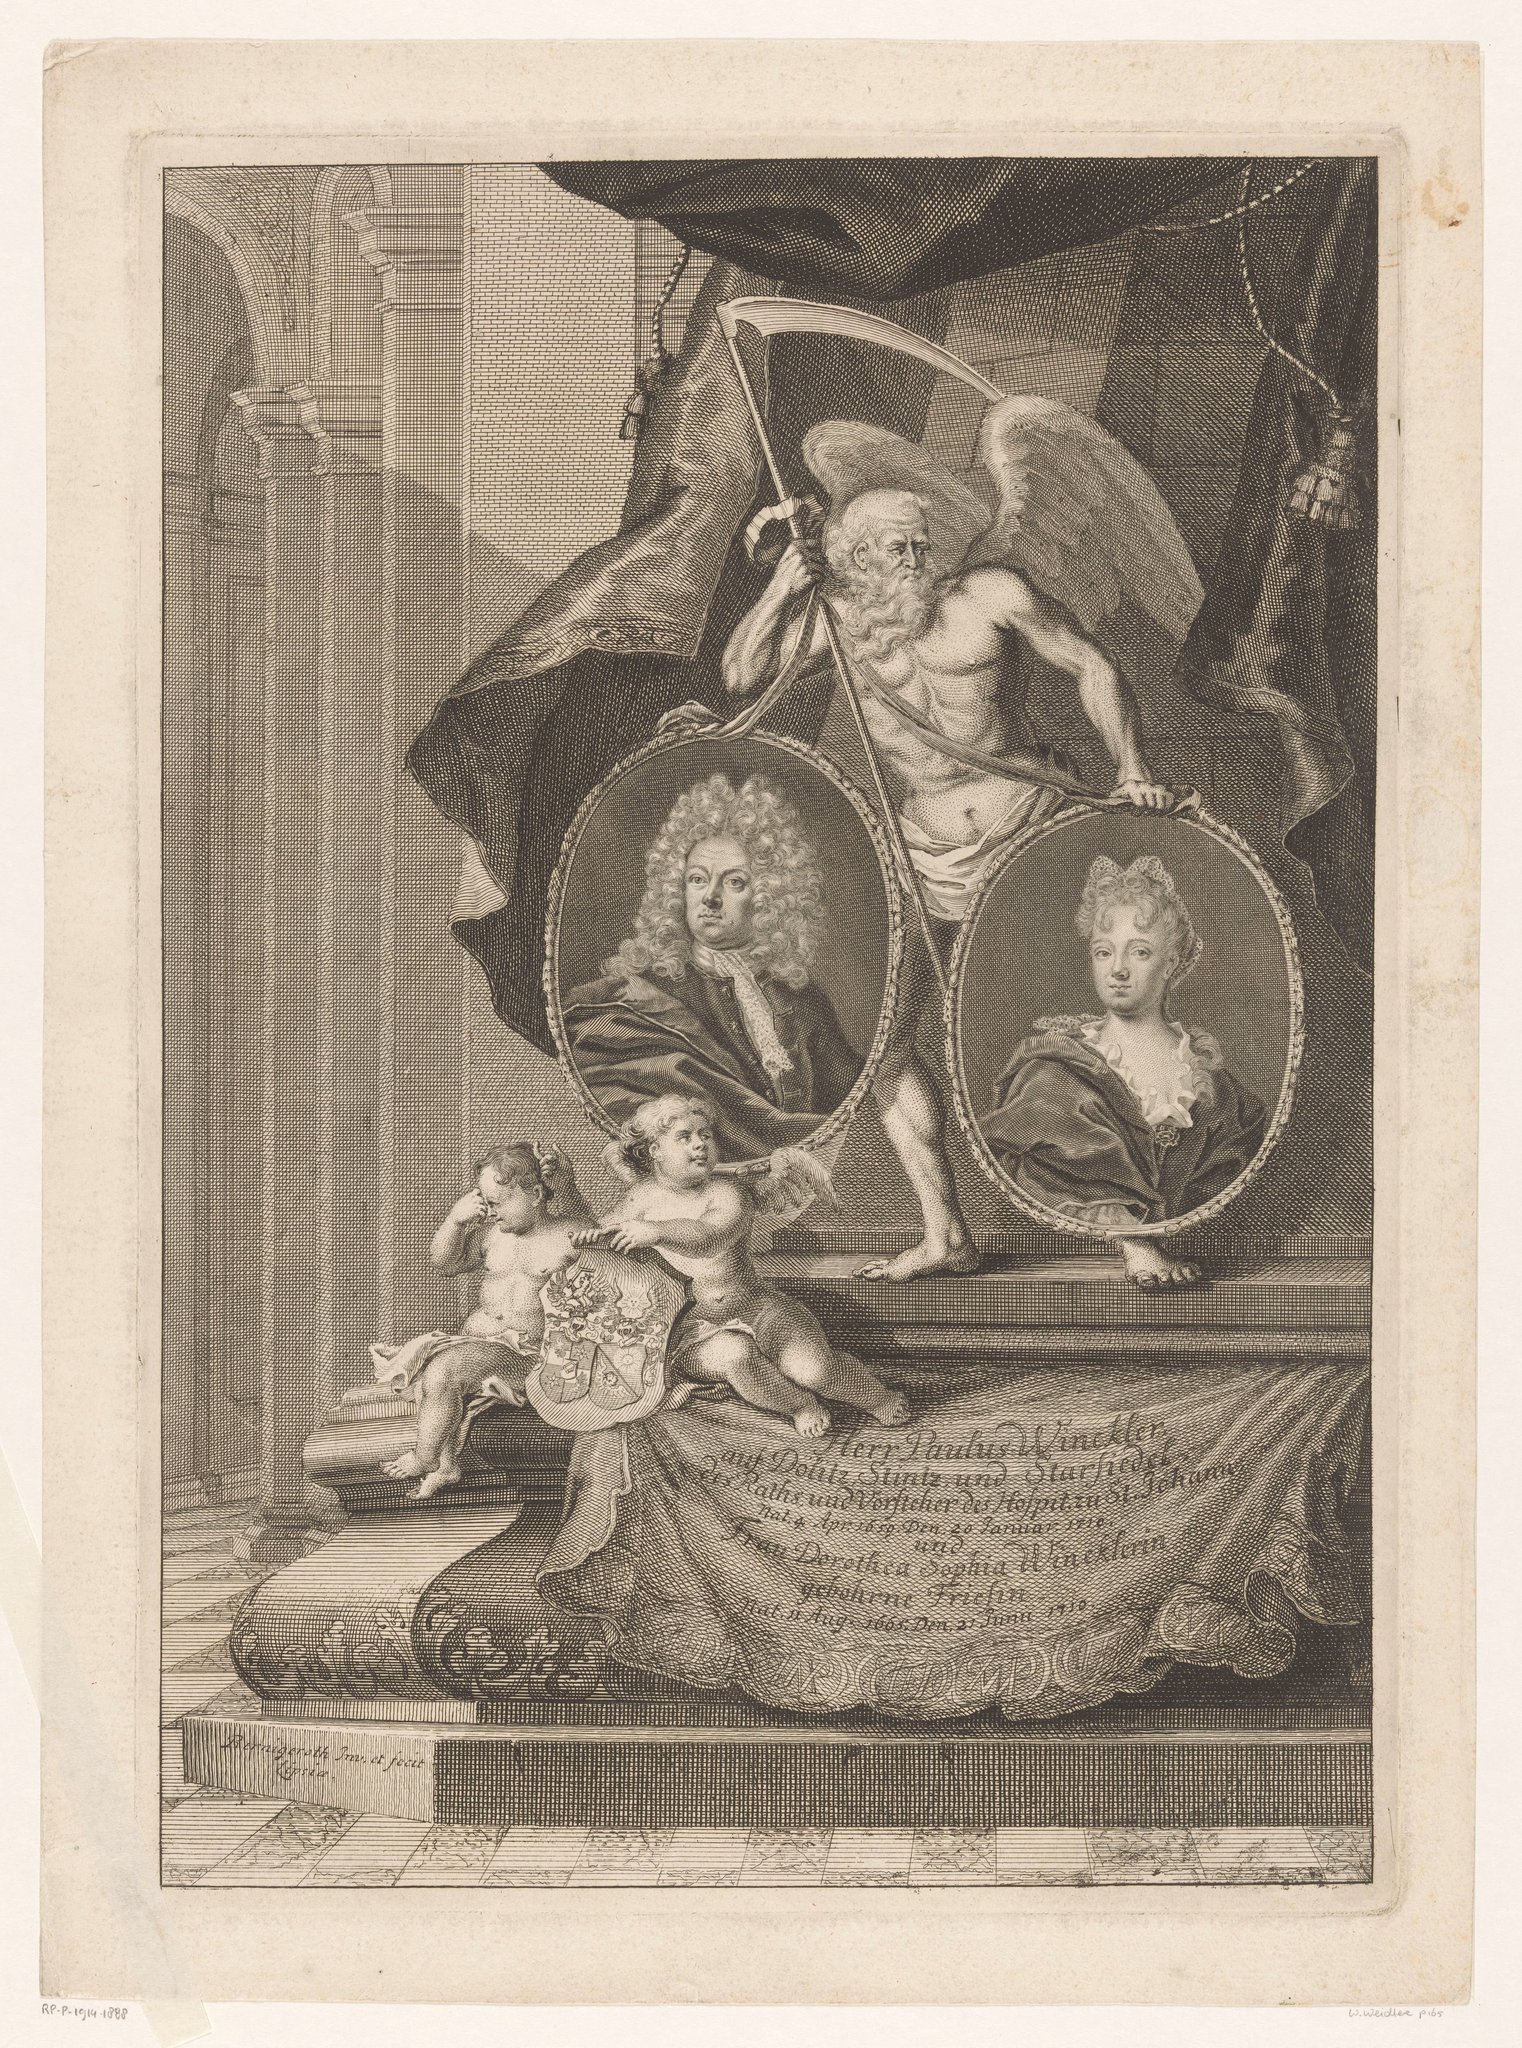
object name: print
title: Grafmonument met de portretten van Paulus Winckler en Dorothea Sophia Winckler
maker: martin bernigeroth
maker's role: print maker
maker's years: 1670-1733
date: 1710-1733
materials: paper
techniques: engraving, etching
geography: leipzig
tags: historical persons - bb - woman, historical persons, grave-building, monumental tomb, cupids: 'amores', 'amoretti', 'putti', father time, man with wings and scythe, armorial bearing, heraldry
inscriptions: collector's mark: Lugt 2228